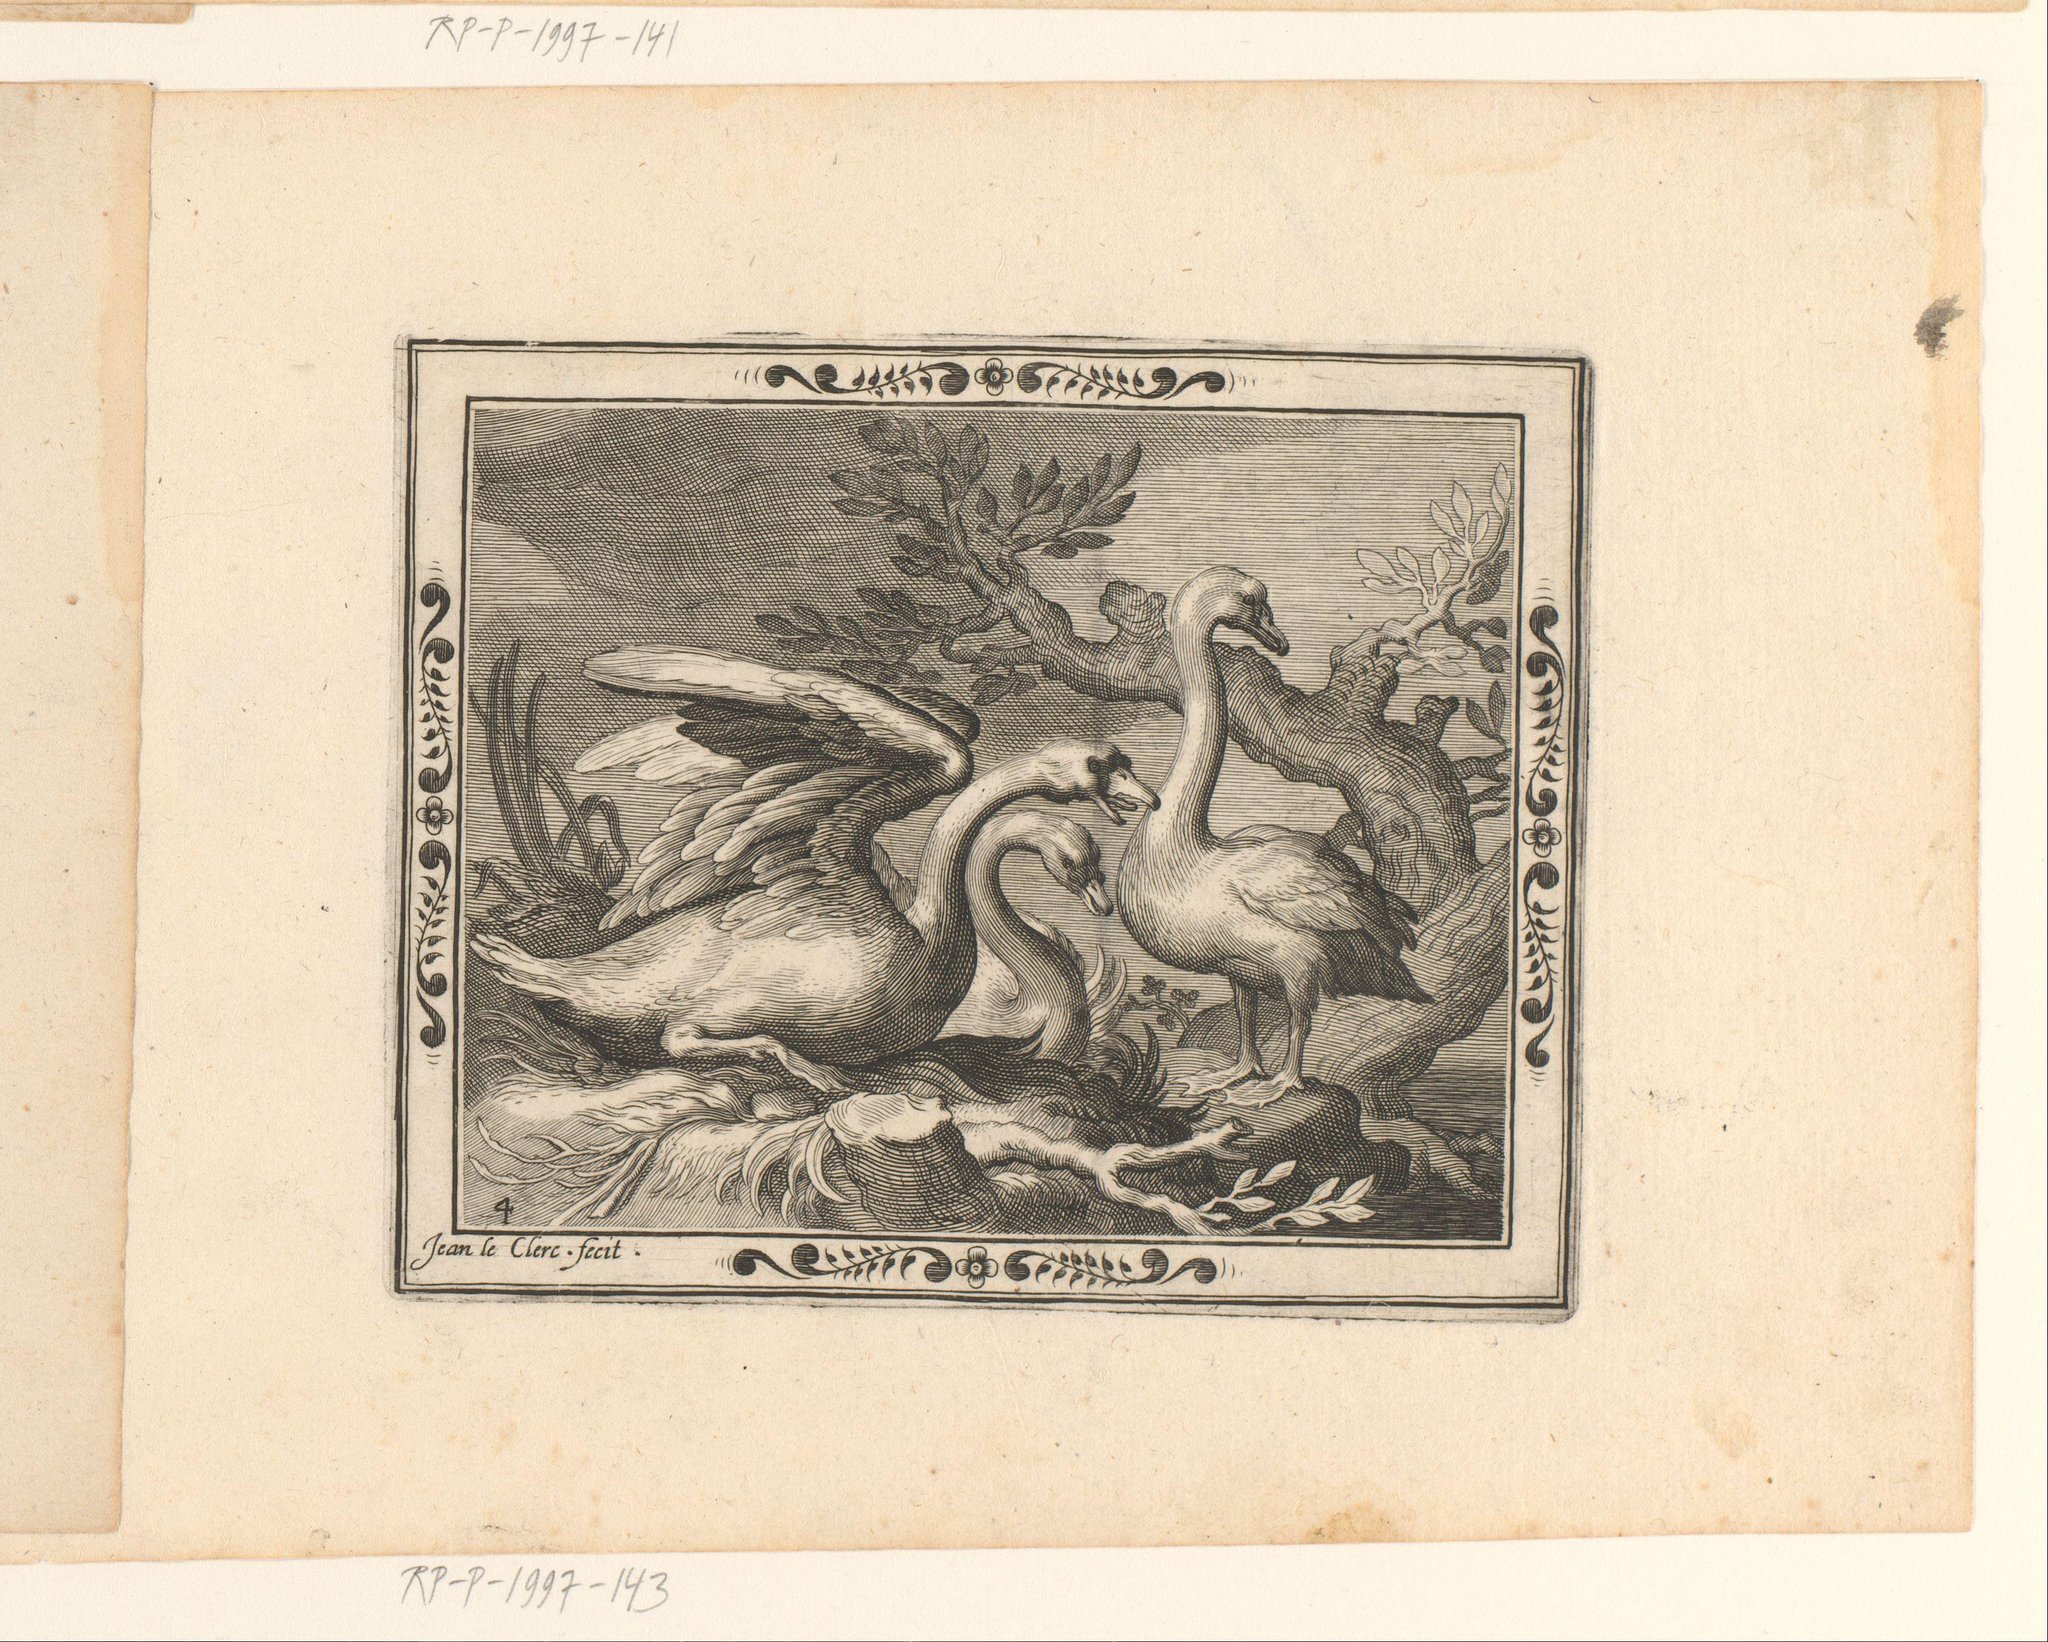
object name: print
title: Diervoorstellingen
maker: jean leclerc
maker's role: print maker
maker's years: 1587-1633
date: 1597-1633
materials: paper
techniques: engraving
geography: france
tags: swans (domestic waterbirds)